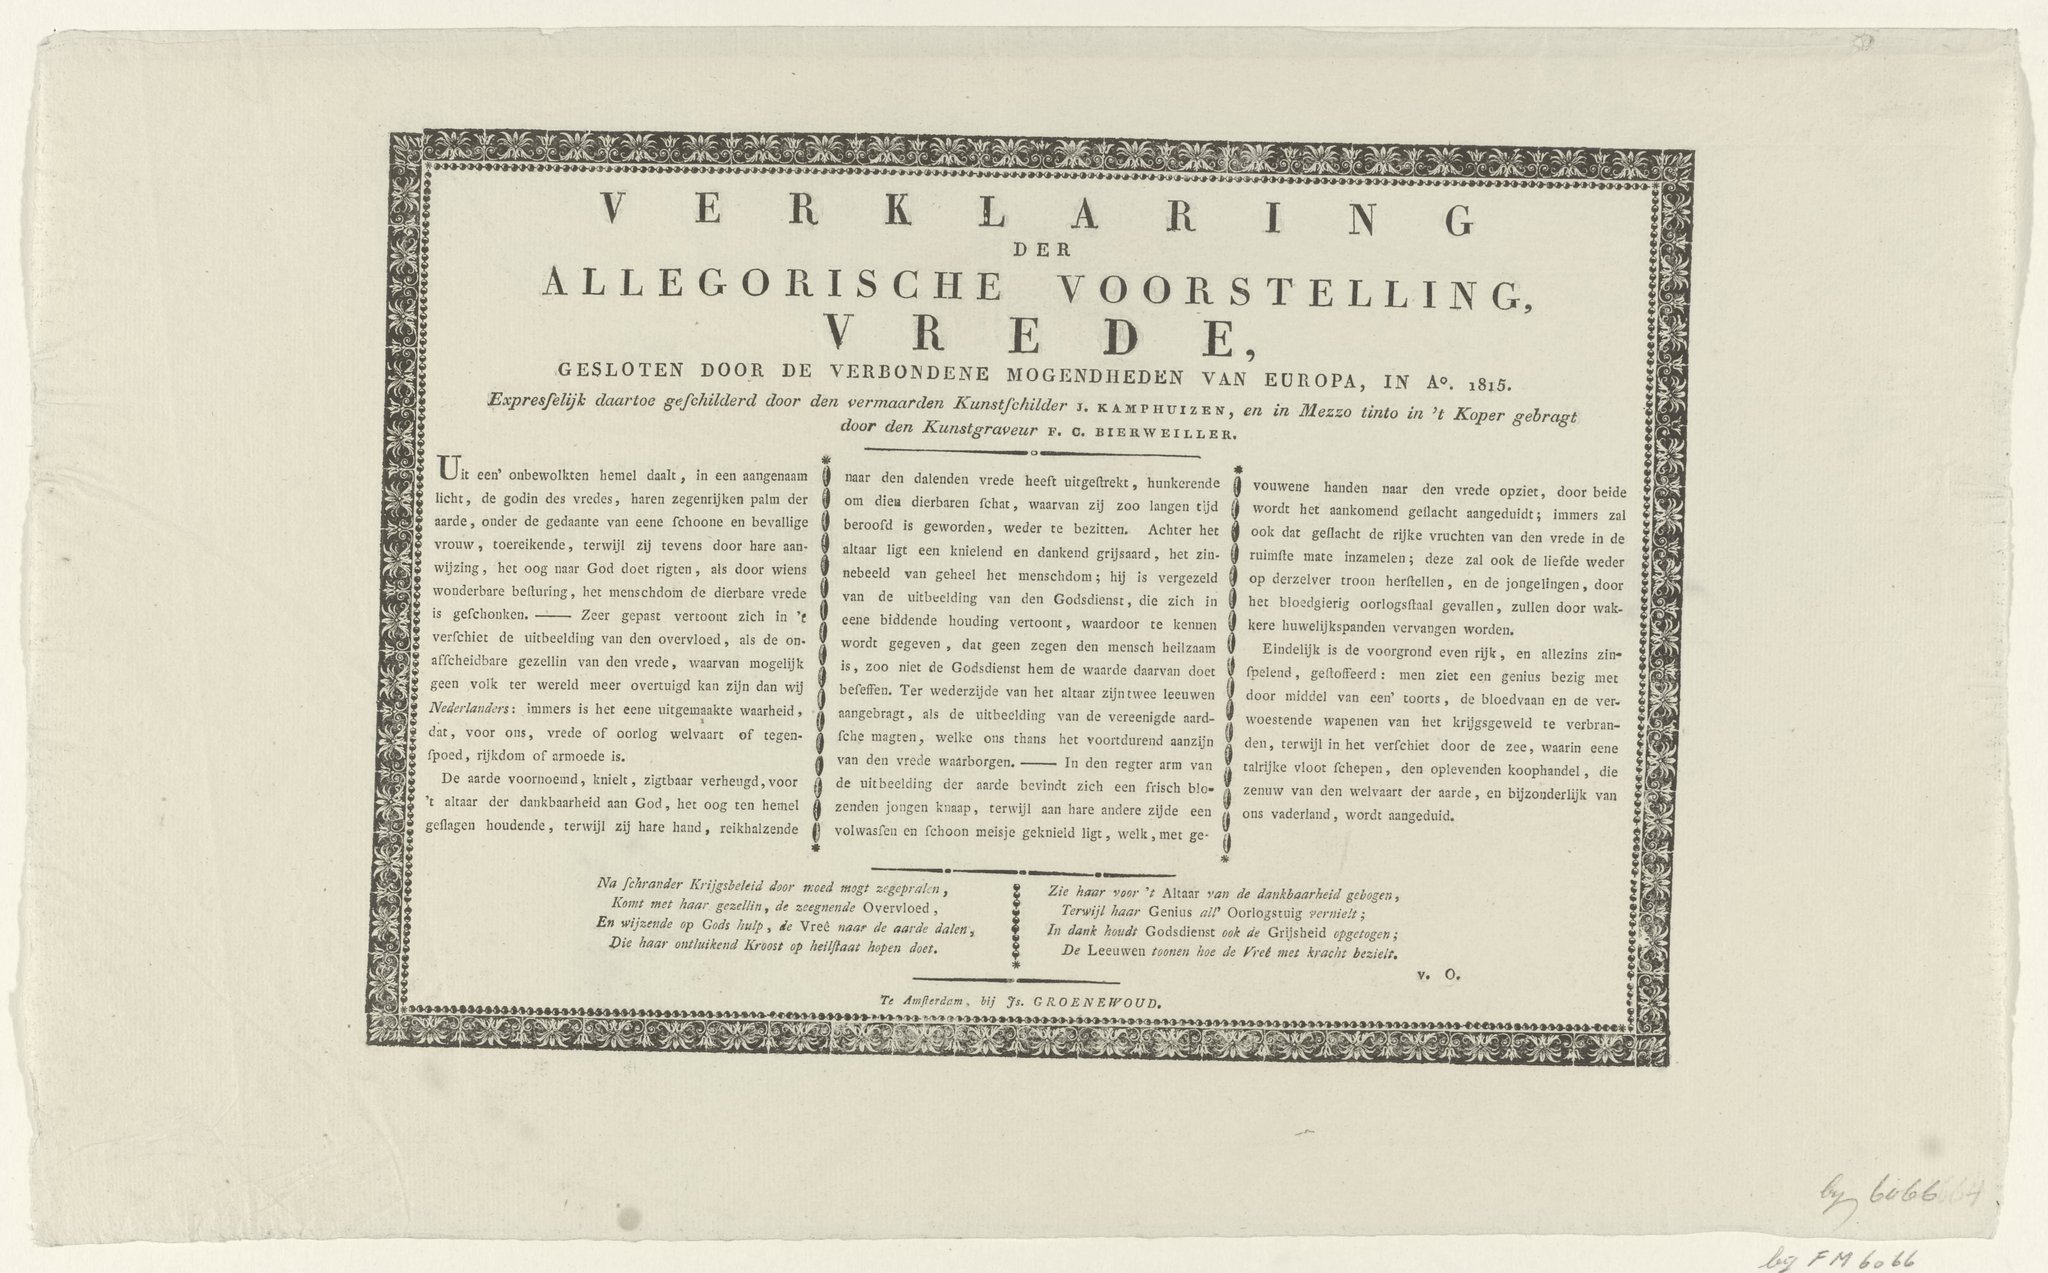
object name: text sheet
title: Verklaring bij de Allegorie op de Tweede Vrede van Parijs, 1815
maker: johannes groenewoud jansz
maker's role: publisher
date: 1815-1816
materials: paper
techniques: letterpress printing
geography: amsterdam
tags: vrede van parijs (1815)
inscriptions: collector's mark: Lugt 2228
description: Tekstblad met een verklaring van de voorstelling van de prent met de allegorie op de Tweede Vrede van Parijs, 20 november 1815. Onder de uitleg dezelfde twee vierreglige verzen in het Nederlands als op de prent, hier gesigneerd 'v.O.'.